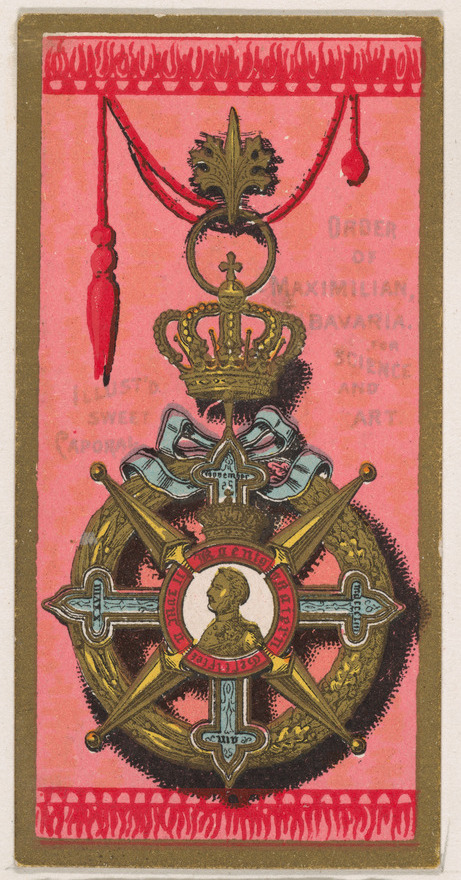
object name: print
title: Order of Maximilian, Bavaria, for Science and Art, from the Military Series (N224) issued by Kinney Tobacco Company to promote Sweet Caporal Cigarettes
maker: kinney brothers tobacco company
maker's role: publisher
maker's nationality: american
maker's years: 1869-2011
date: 1888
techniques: color lithograph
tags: men,profiles